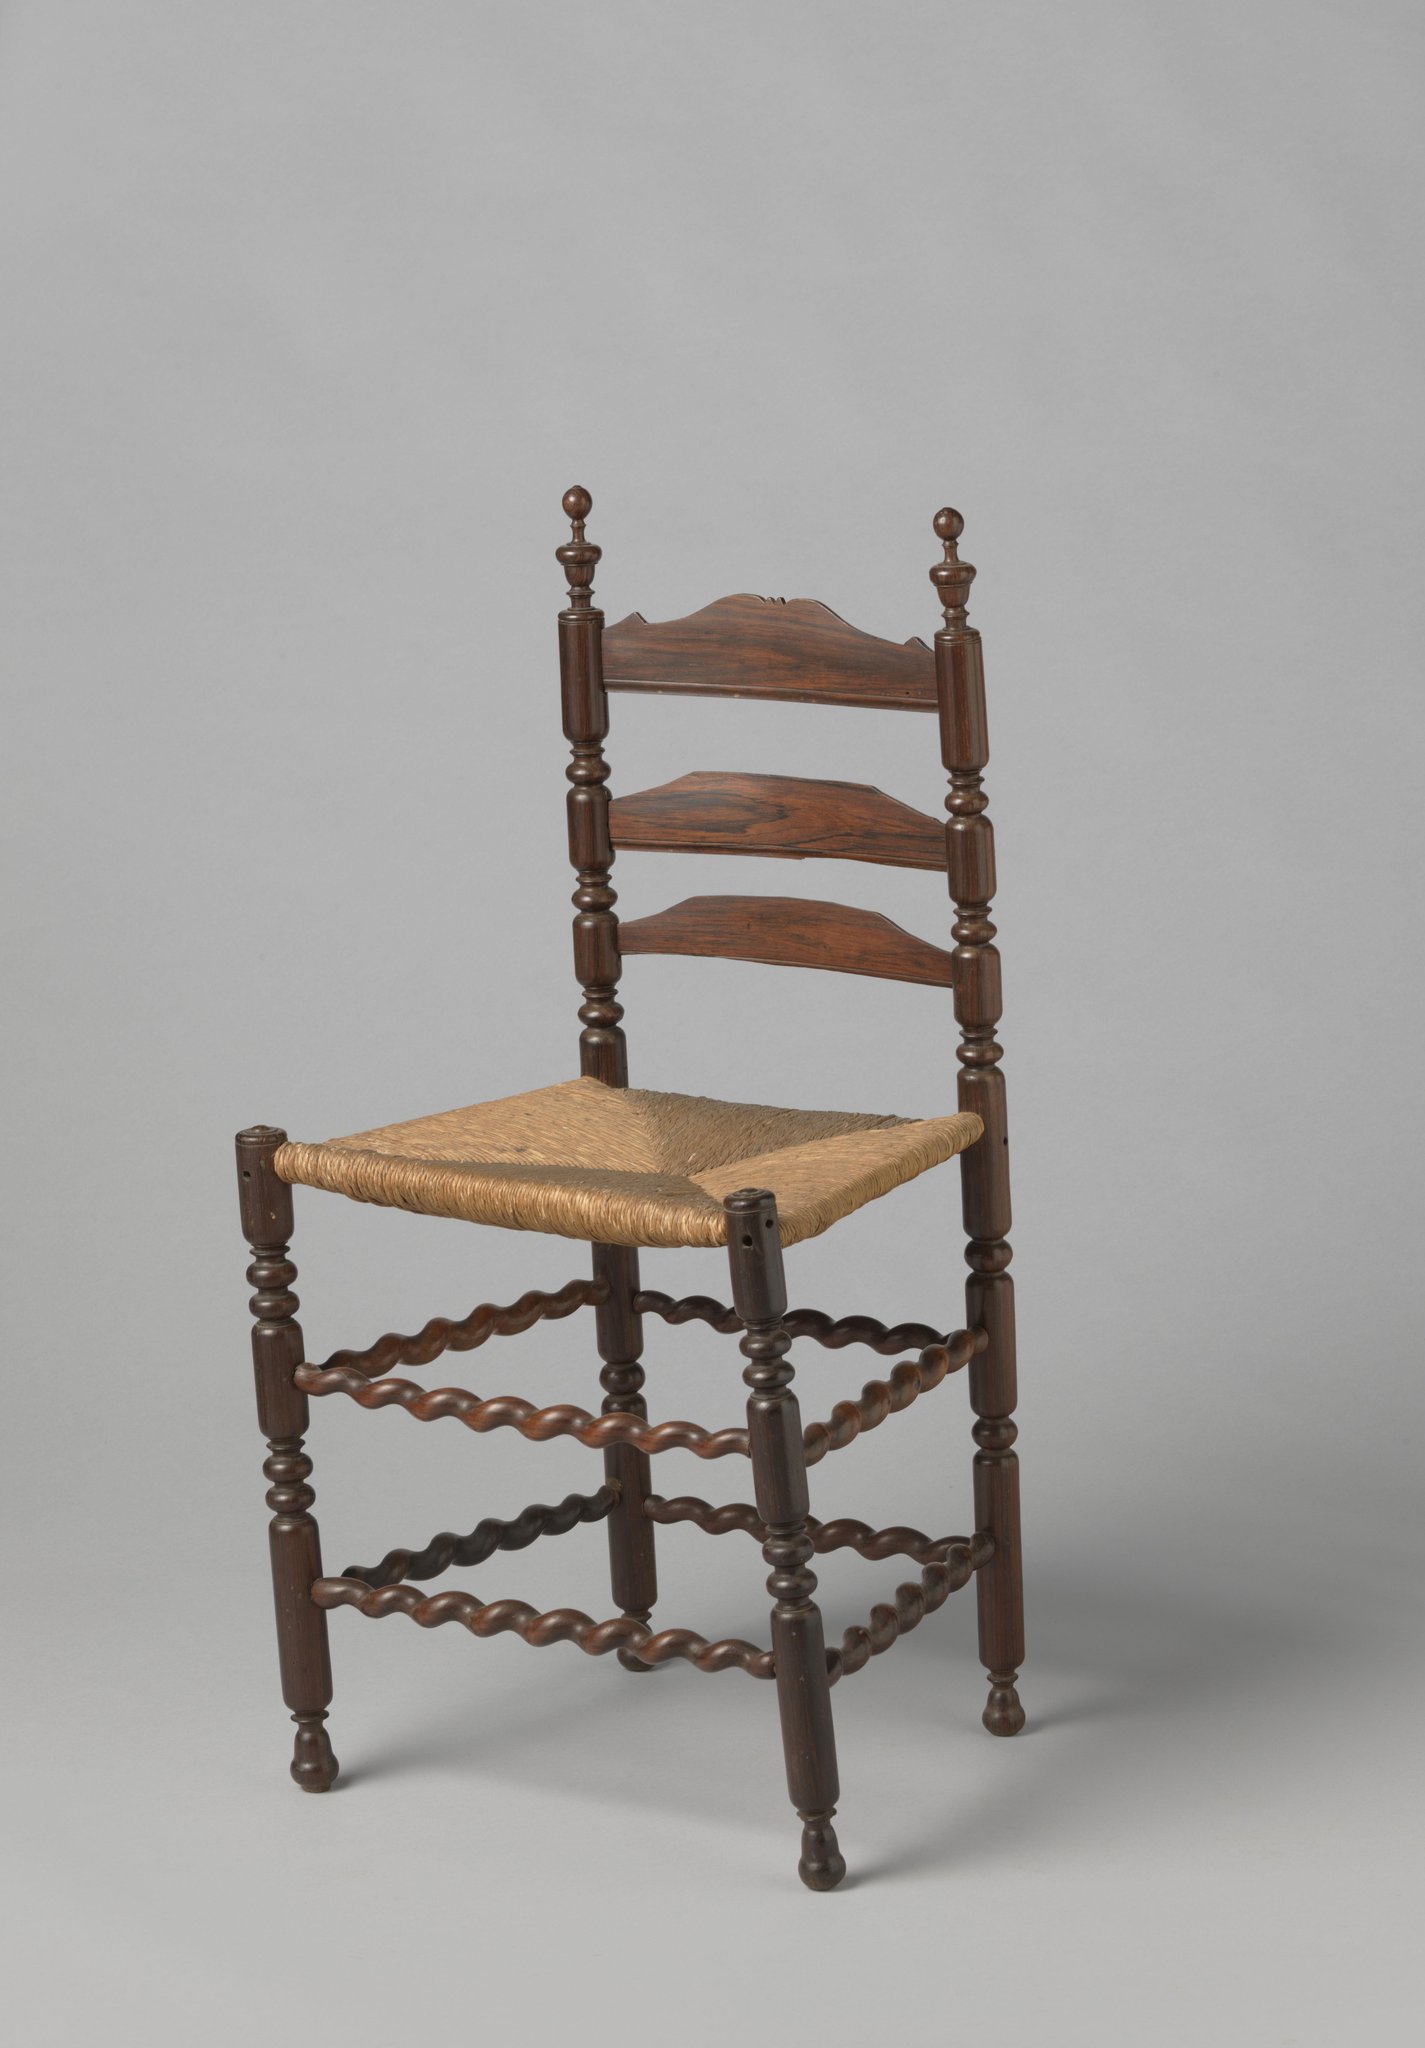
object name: chair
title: Stoel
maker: Anonymous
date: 1700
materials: wood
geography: northern netherlands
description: Stoel van palissanderhout met matten zitting. De poten vertonen gedraaide geledingen en zijn door acht geslingerde sporten verbonden. De rugstijlen zijn behandeld als de poten en eindigen bovenaan in gedraaide vaasjes met bollen en zijn verbonden door drie licht geholde, platte sporten, waarvan de bovenste aan de bovenzijde geschulpt is. Enige sporten zijn van notenhout.